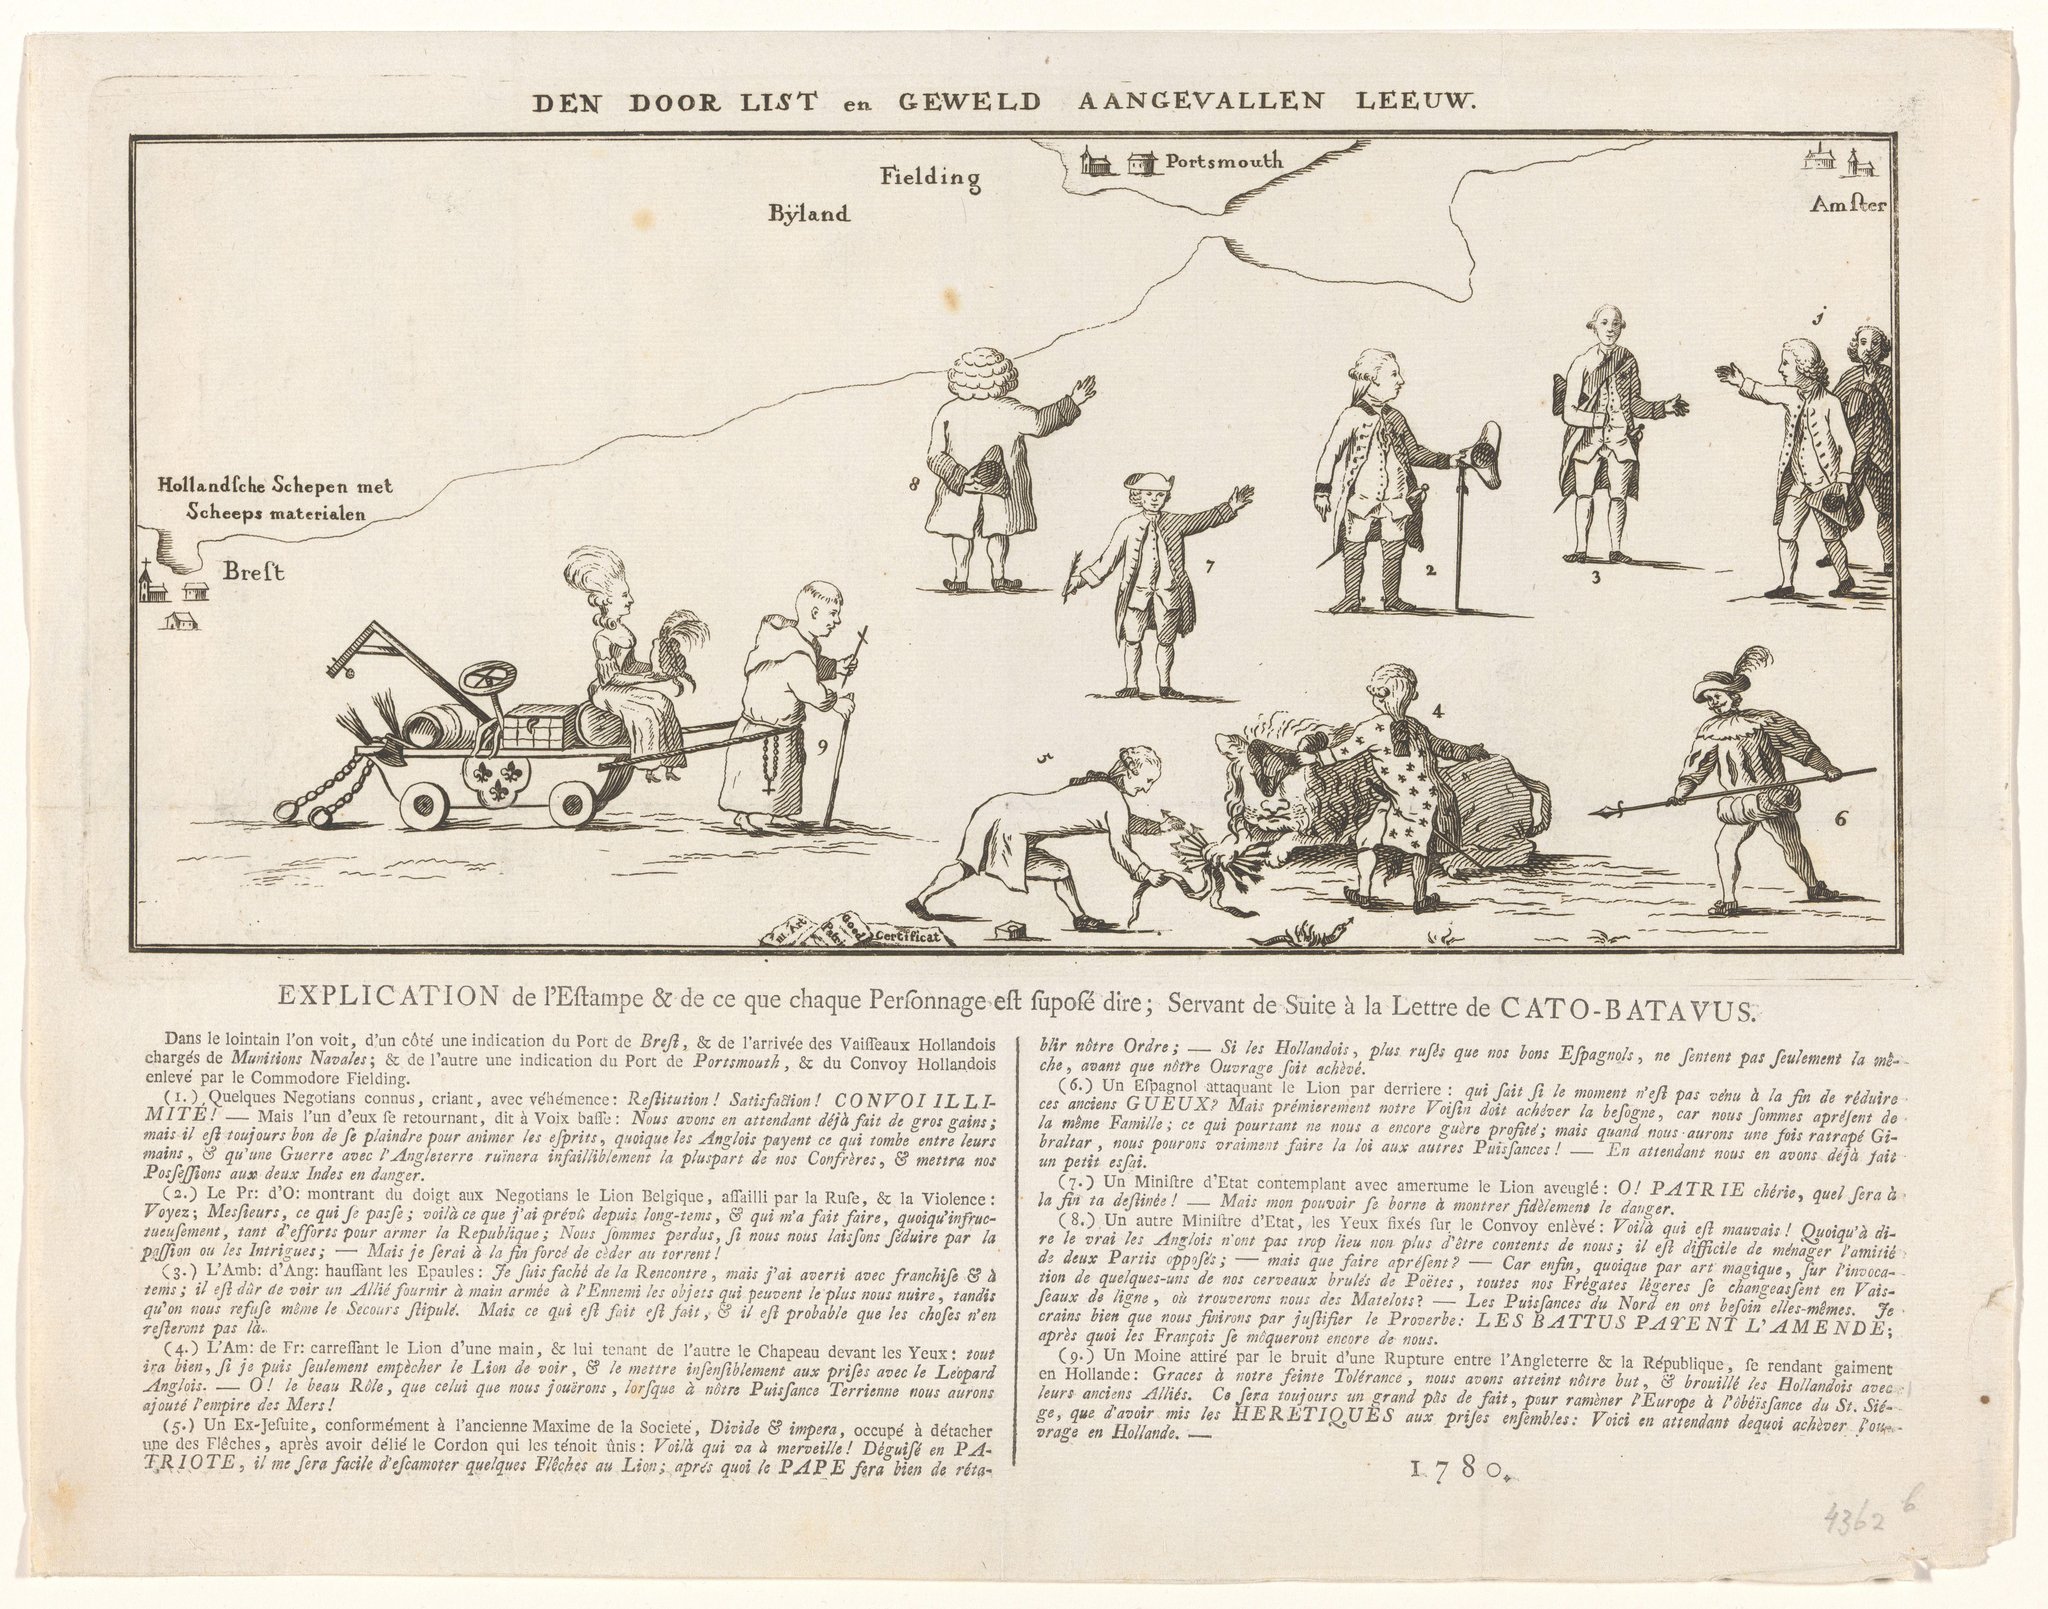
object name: cartoon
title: Den door List en Geweld Aangevallen Leeuw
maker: Anonymous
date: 1780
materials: paper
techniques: etching, letterpress printing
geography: northern netherlands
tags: political caricatures and satires, fourth anglo-dutch war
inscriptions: collector's mark: Lugt 240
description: De Nederlandse Leeuw door list en geweld aangevallen. Spotprent op de politieke gebeurtenissen in het jaar 1780. De Nederlandse Leeuw wordt verblind door een Fransman en aangevallen door een Spanjaard en een ex-jezuïet. Op een kaart zijn de plaatsen Portsmouth, Amsterdam en Brest aangeduid. Links trekt een monnik een kar richting Nederland. Op het blad onder de plaat de verklaring van de cijfers 1-9 in het Frans.